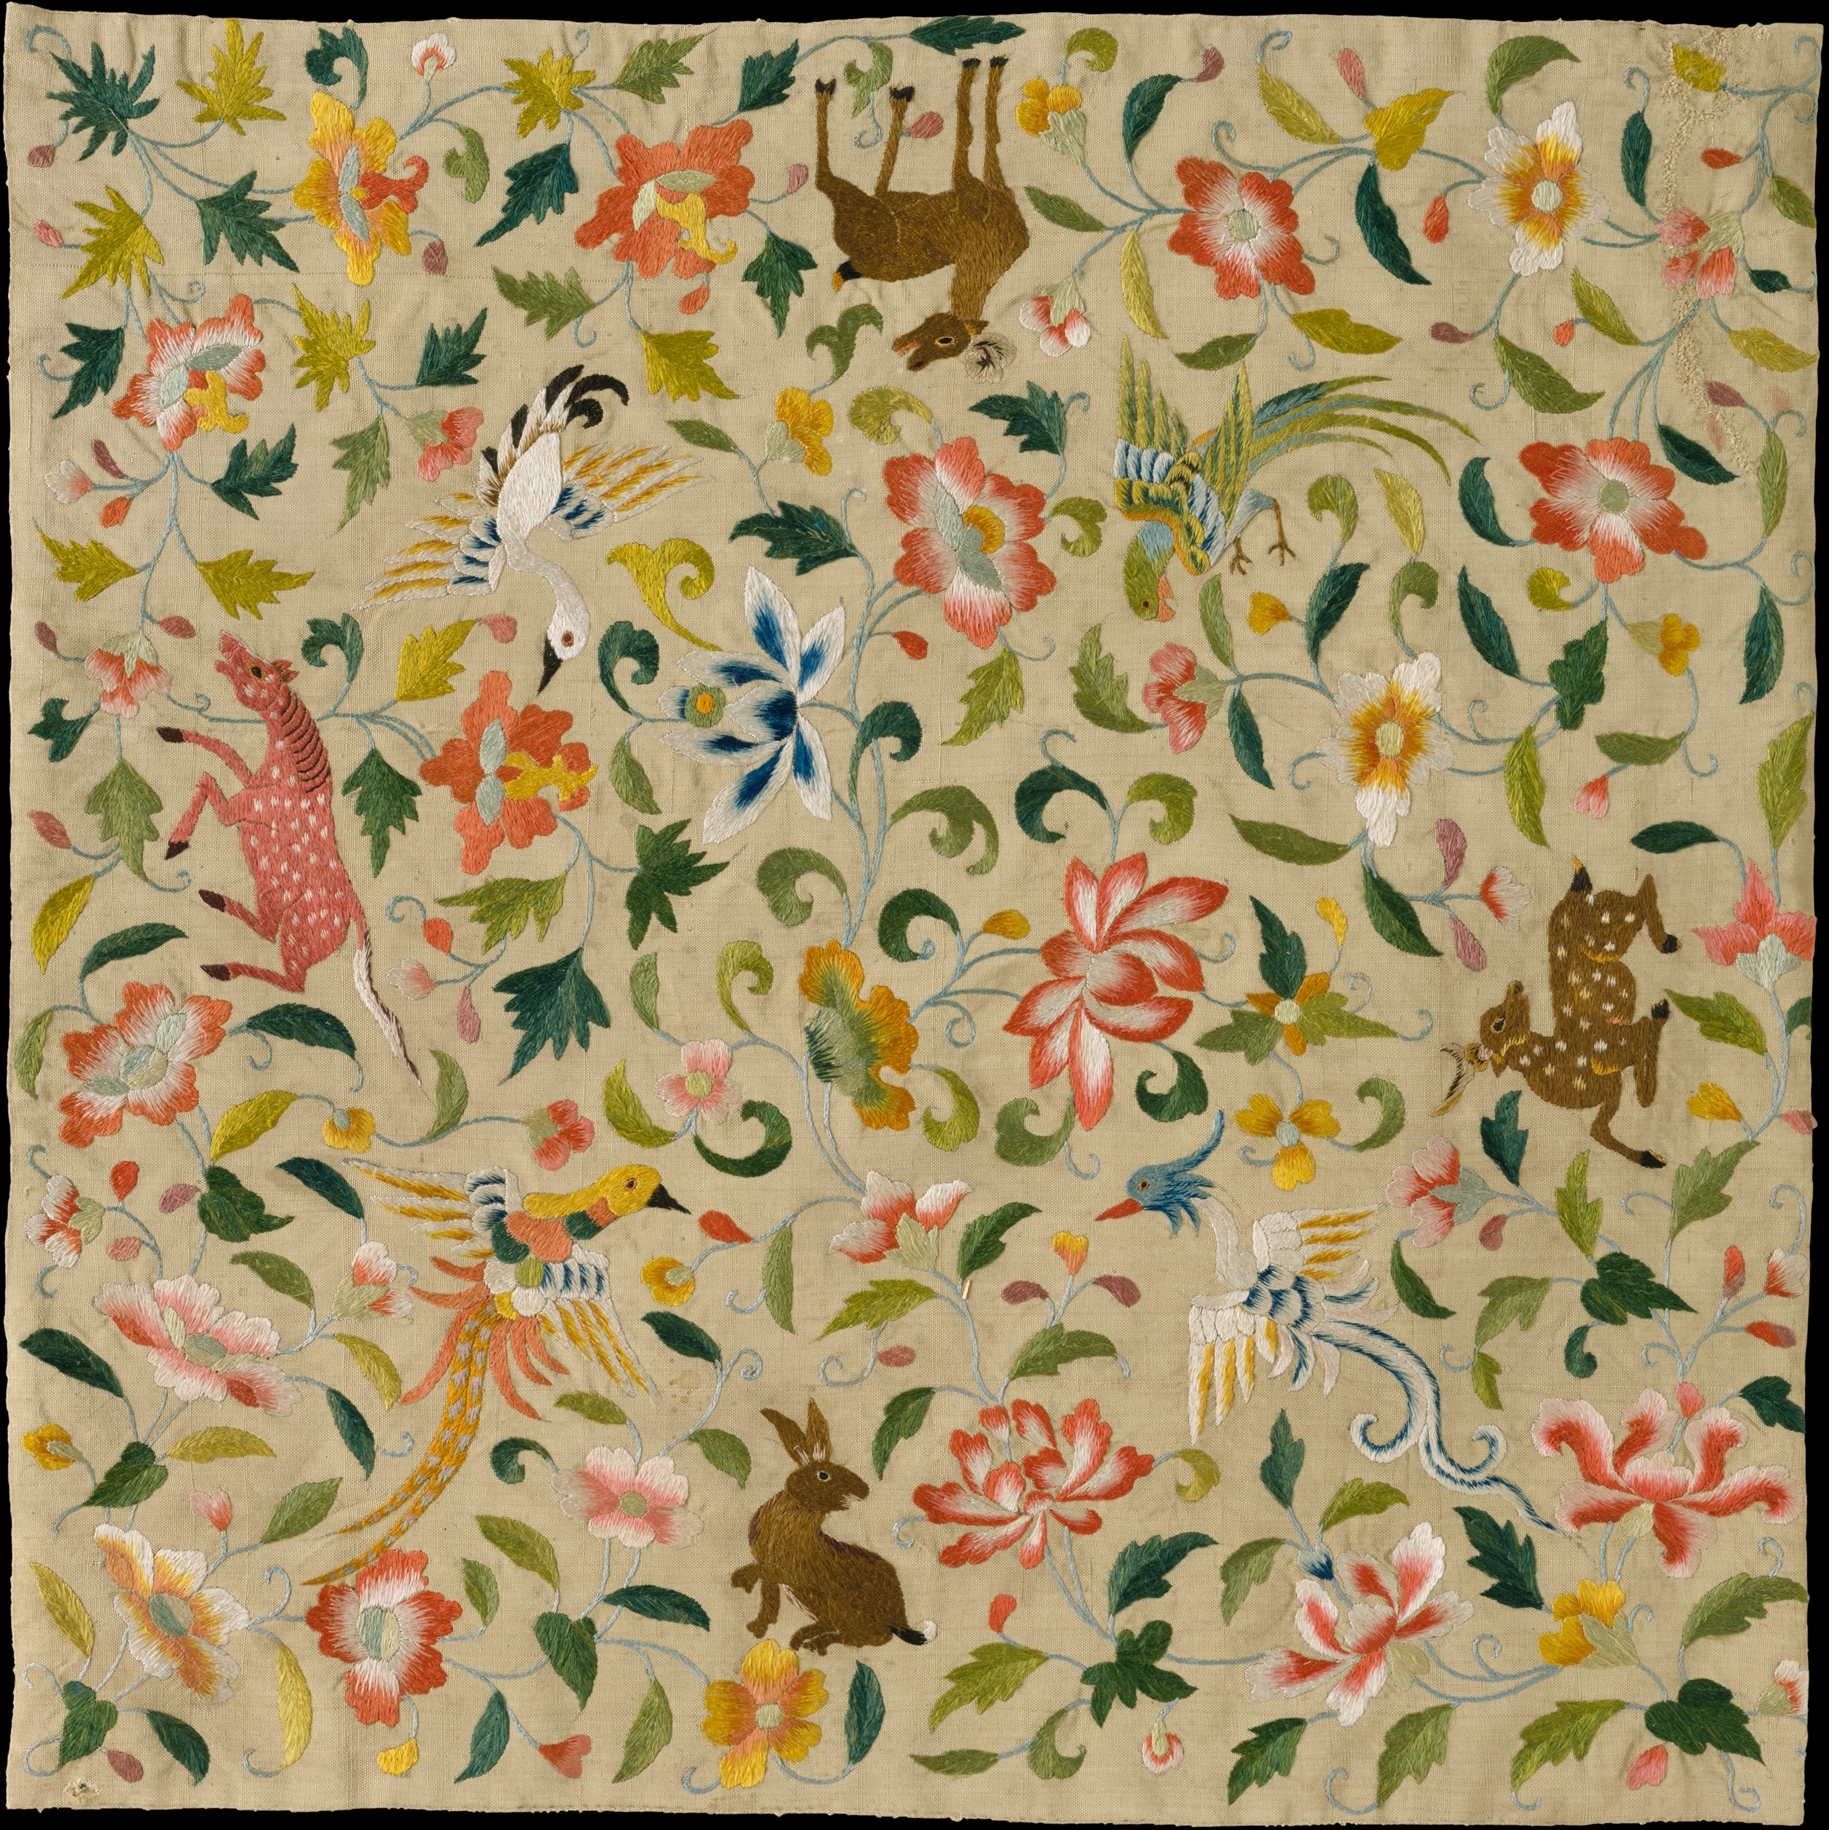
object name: square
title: Textile with Animals, Birds, and Flowers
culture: eastern central asian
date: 1167-1400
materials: silk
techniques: embroidery, weave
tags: parrots,deer,horses,rabbits